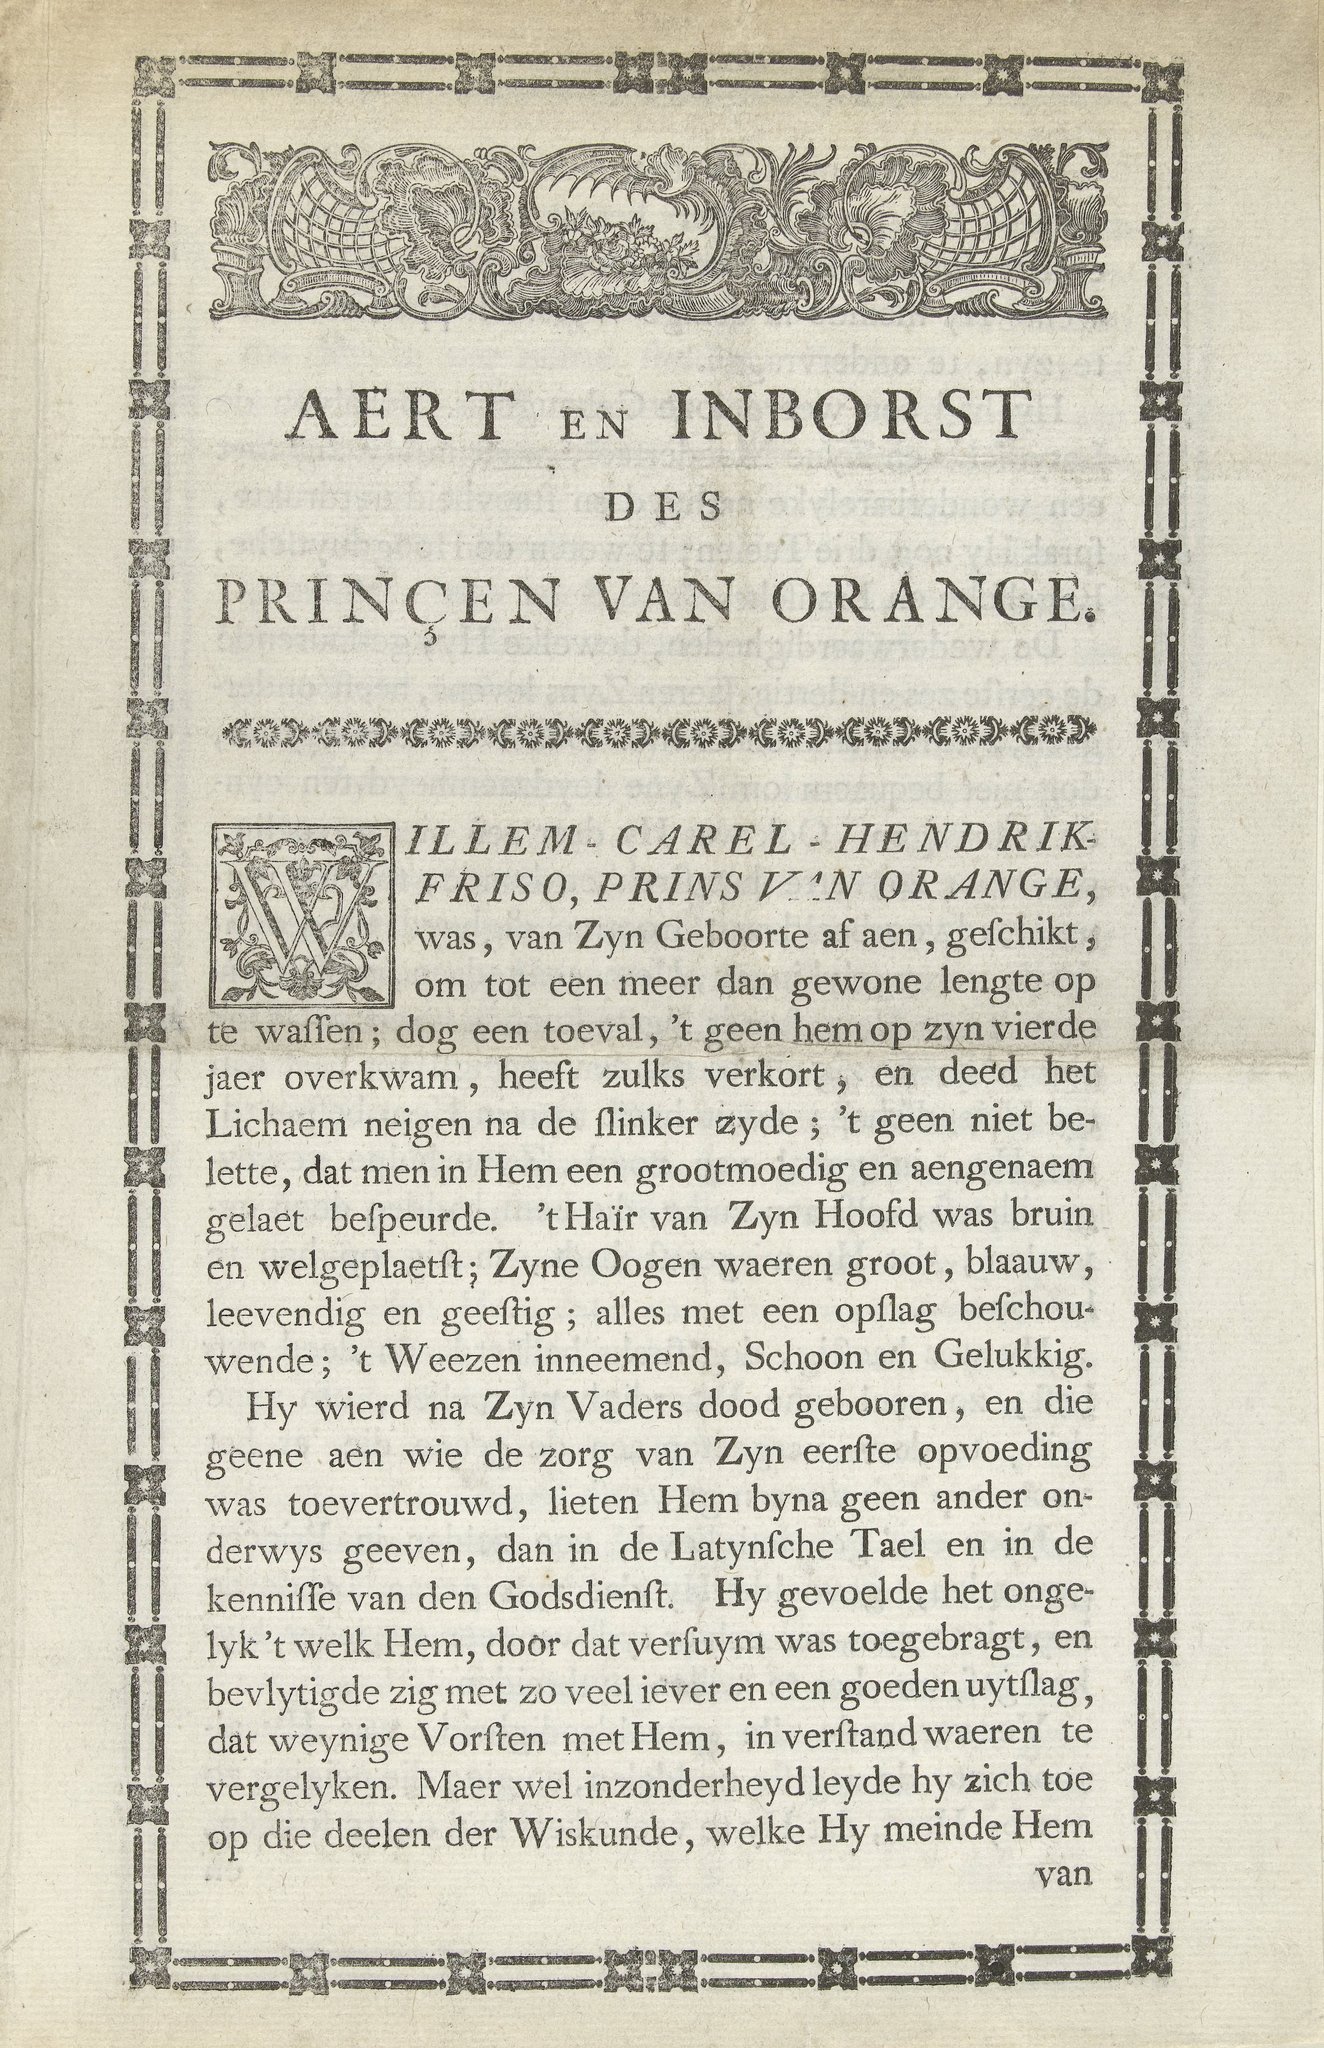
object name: pamphlet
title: Pamflet op Willem IV bij zijn overlijden, 1751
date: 1751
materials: paper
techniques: letterpress printing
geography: the hague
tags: the hague, willem iv (prins van oranje-nassau)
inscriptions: collector's mark: Lugt 2760, collector's mark: Lugt 2228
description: Pamflet op de persoonlijkheid van de prins en stadhouder Willem IV bij zijn overlijden, 22 oktober 1751. Dubbelgevouwen blad op vier zijden bedrukt met tekst in lijst met vignetten aan het begin en eind.